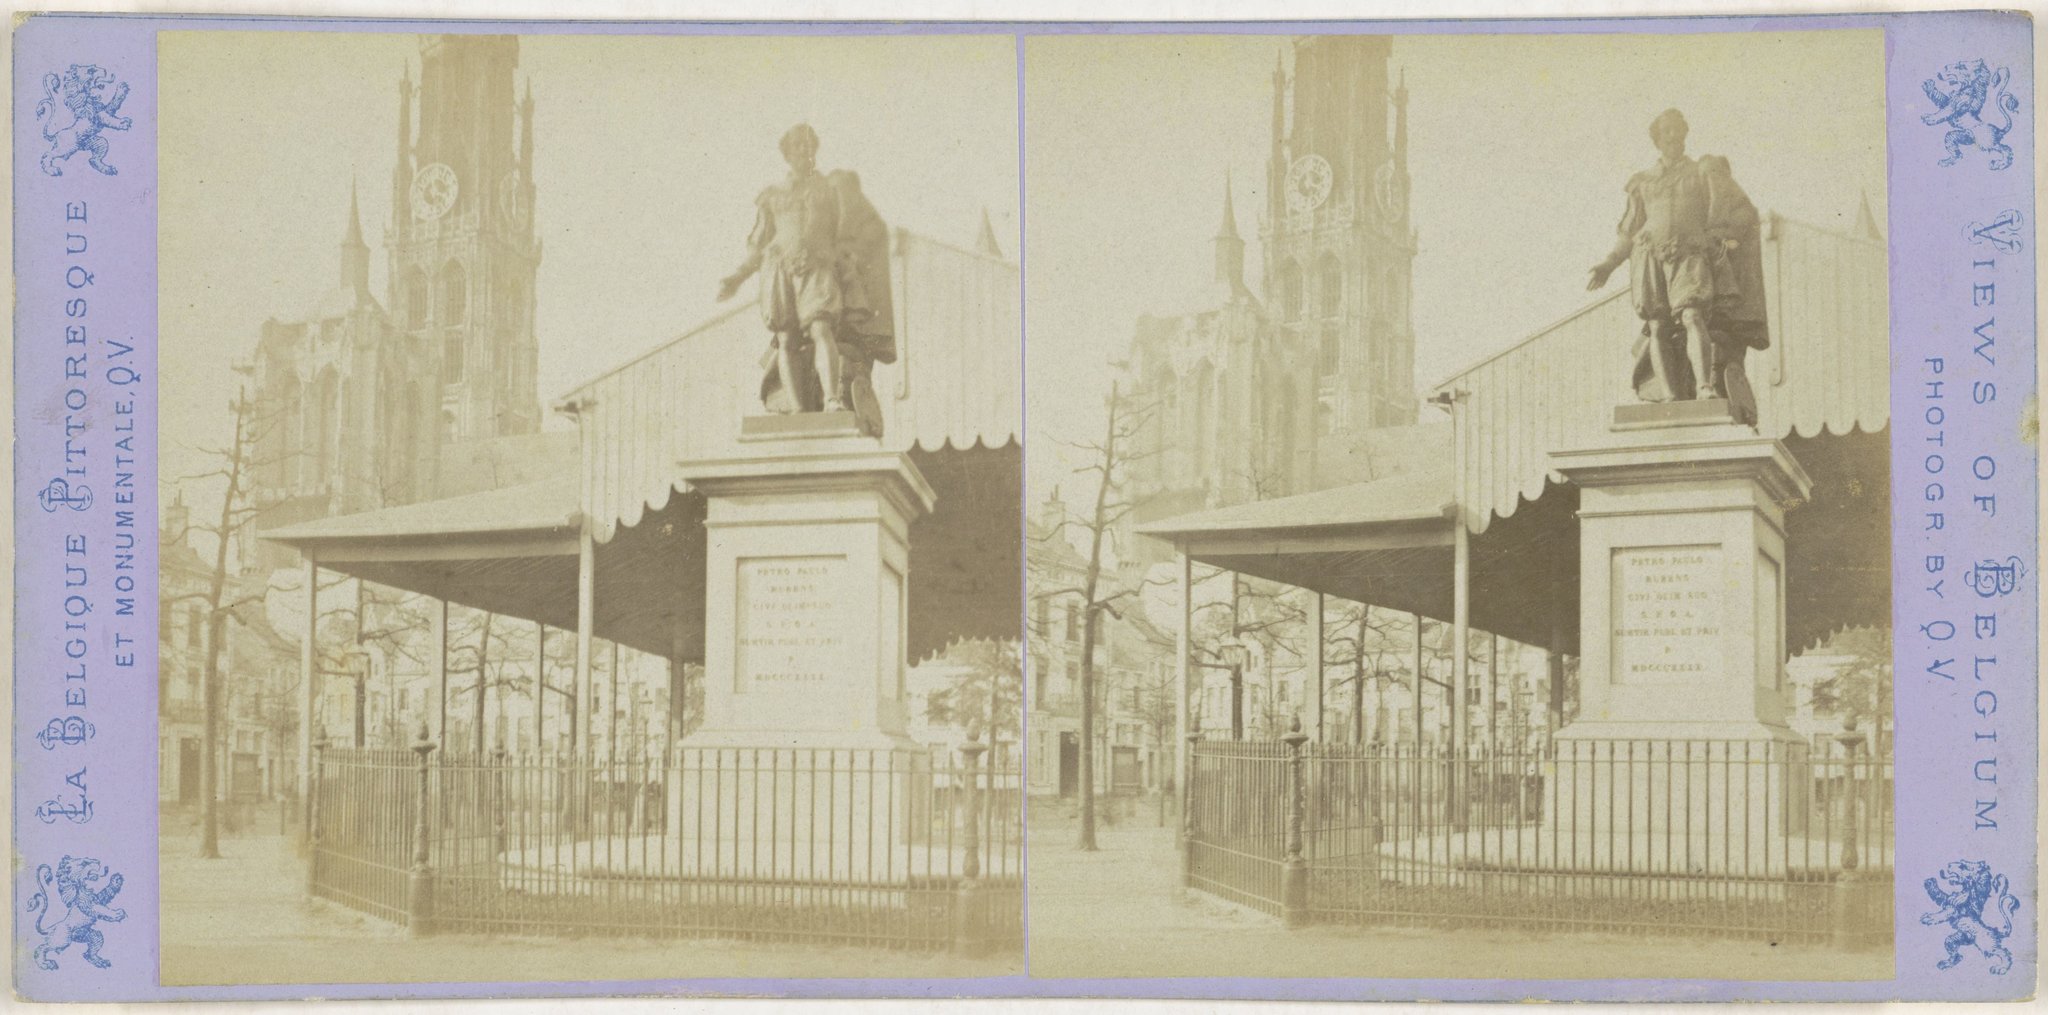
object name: stereograph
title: Anvers, le statue de Rubens sur la Place-Verte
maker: jules hippolyte quéval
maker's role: publisher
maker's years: 1824-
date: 1866-1870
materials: cardboard, paper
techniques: albumen print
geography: antwerp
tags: antwerp, painter, print maker, draughtsman, peter paul rubens, square, place, circus, etc., monument, statue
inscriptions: number: ‘No 1643’